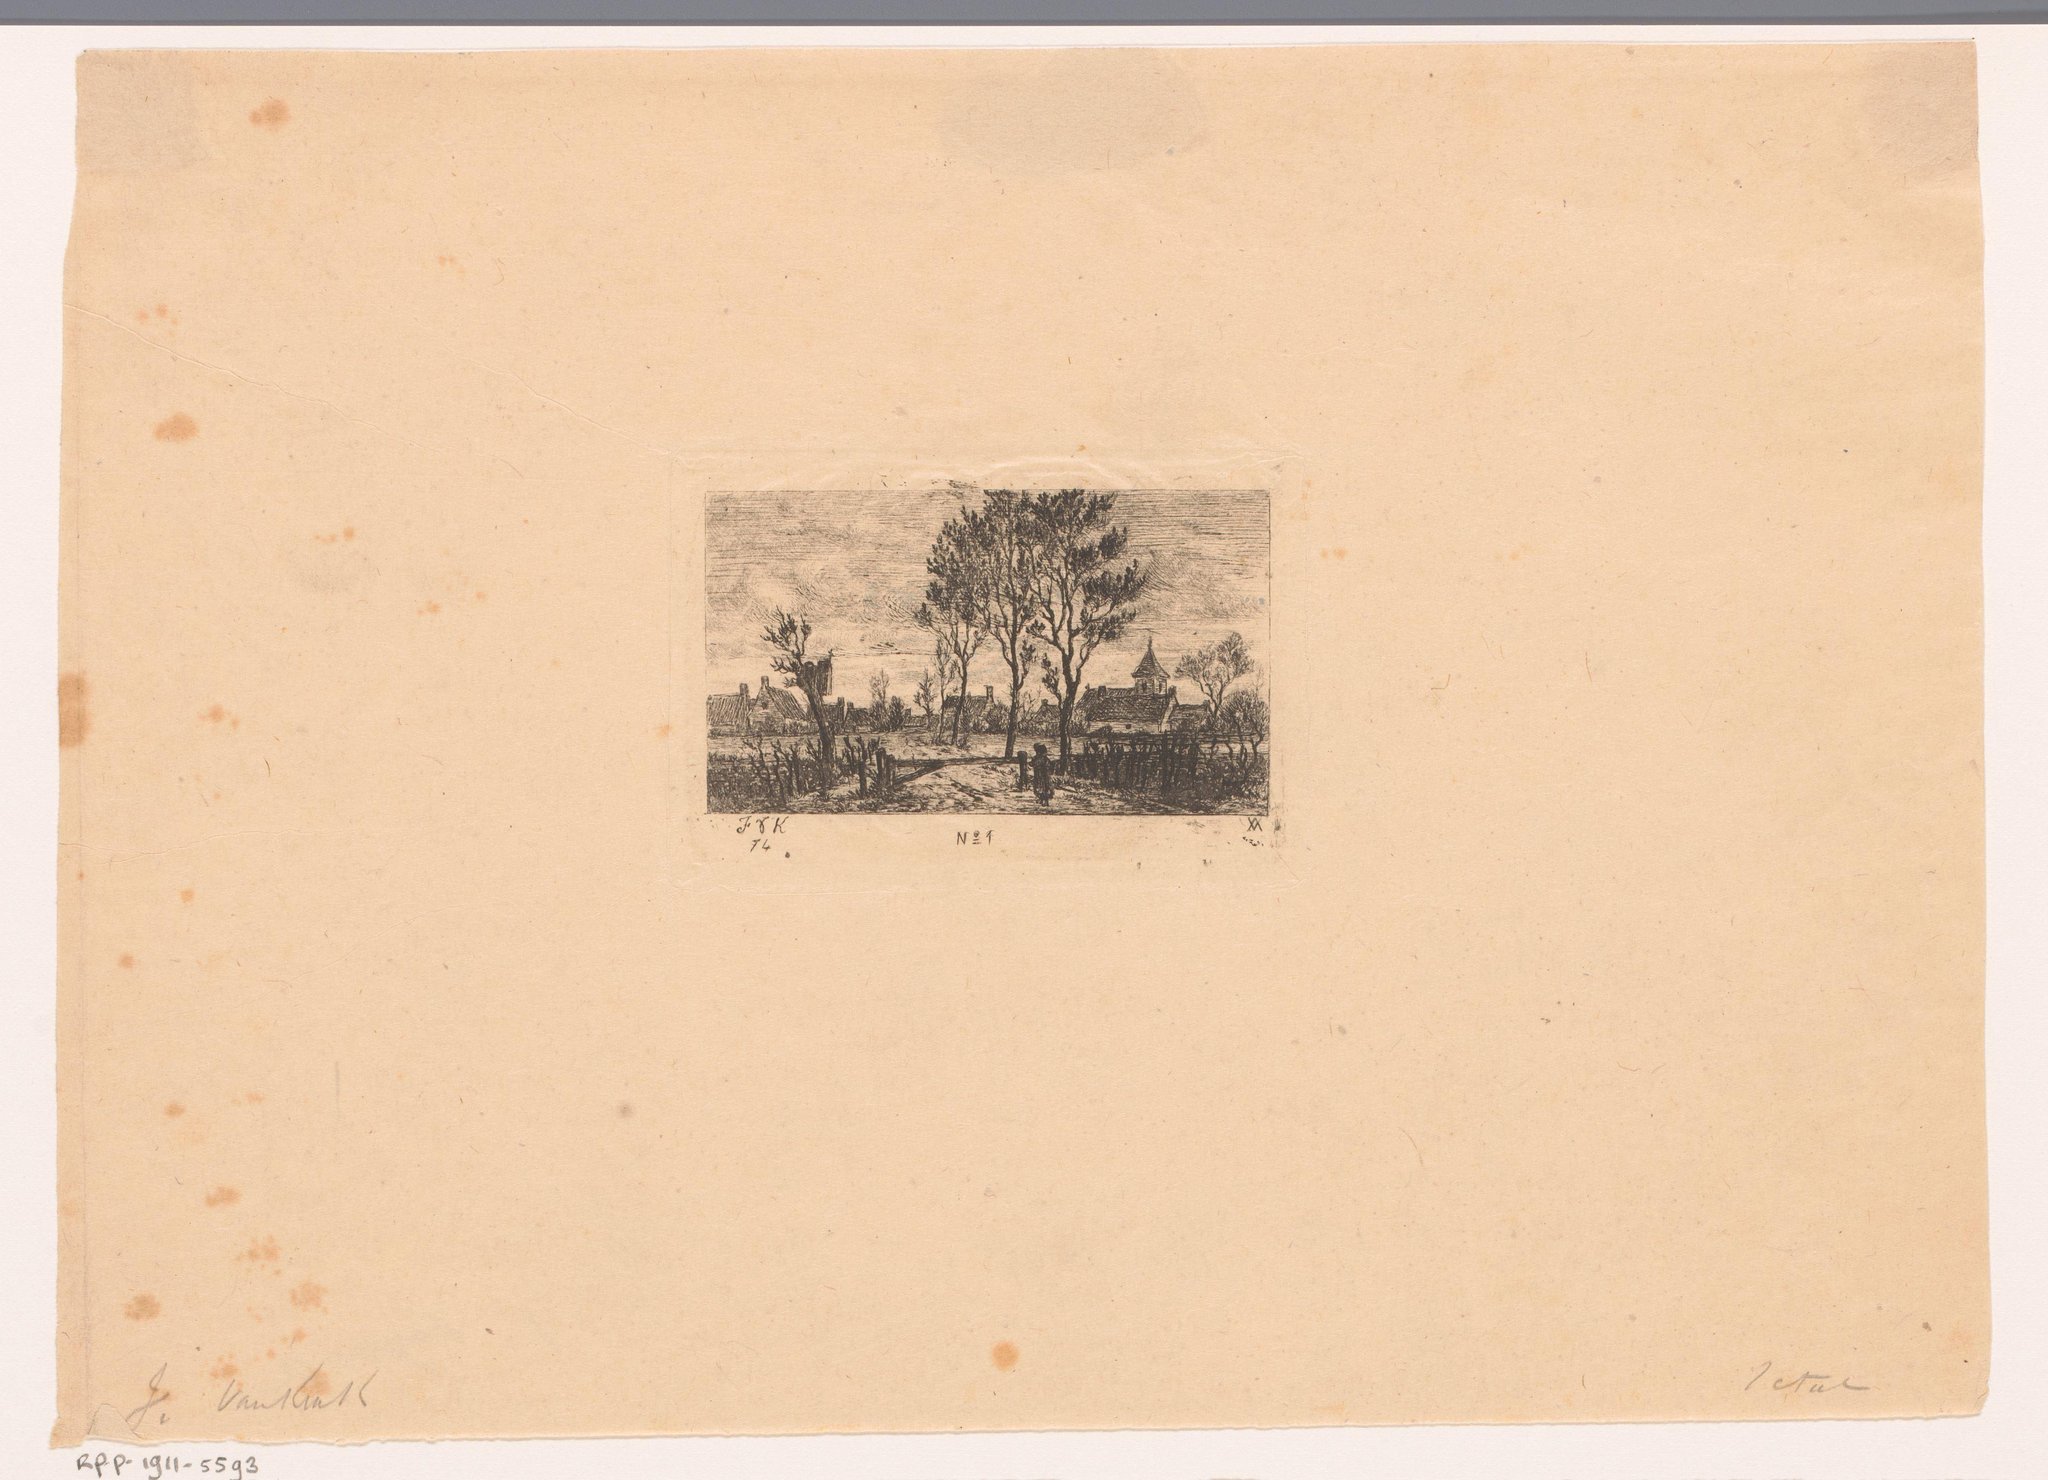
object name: print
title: Landschap met stadsgezicht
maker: frans van kuyck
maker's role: painter, print maker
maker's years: 1852-1915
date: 1874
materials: paper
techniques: etching, intaglio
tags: prospect of city, town panorama, silhouette of city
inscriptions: collector's mark: Lugt 2228